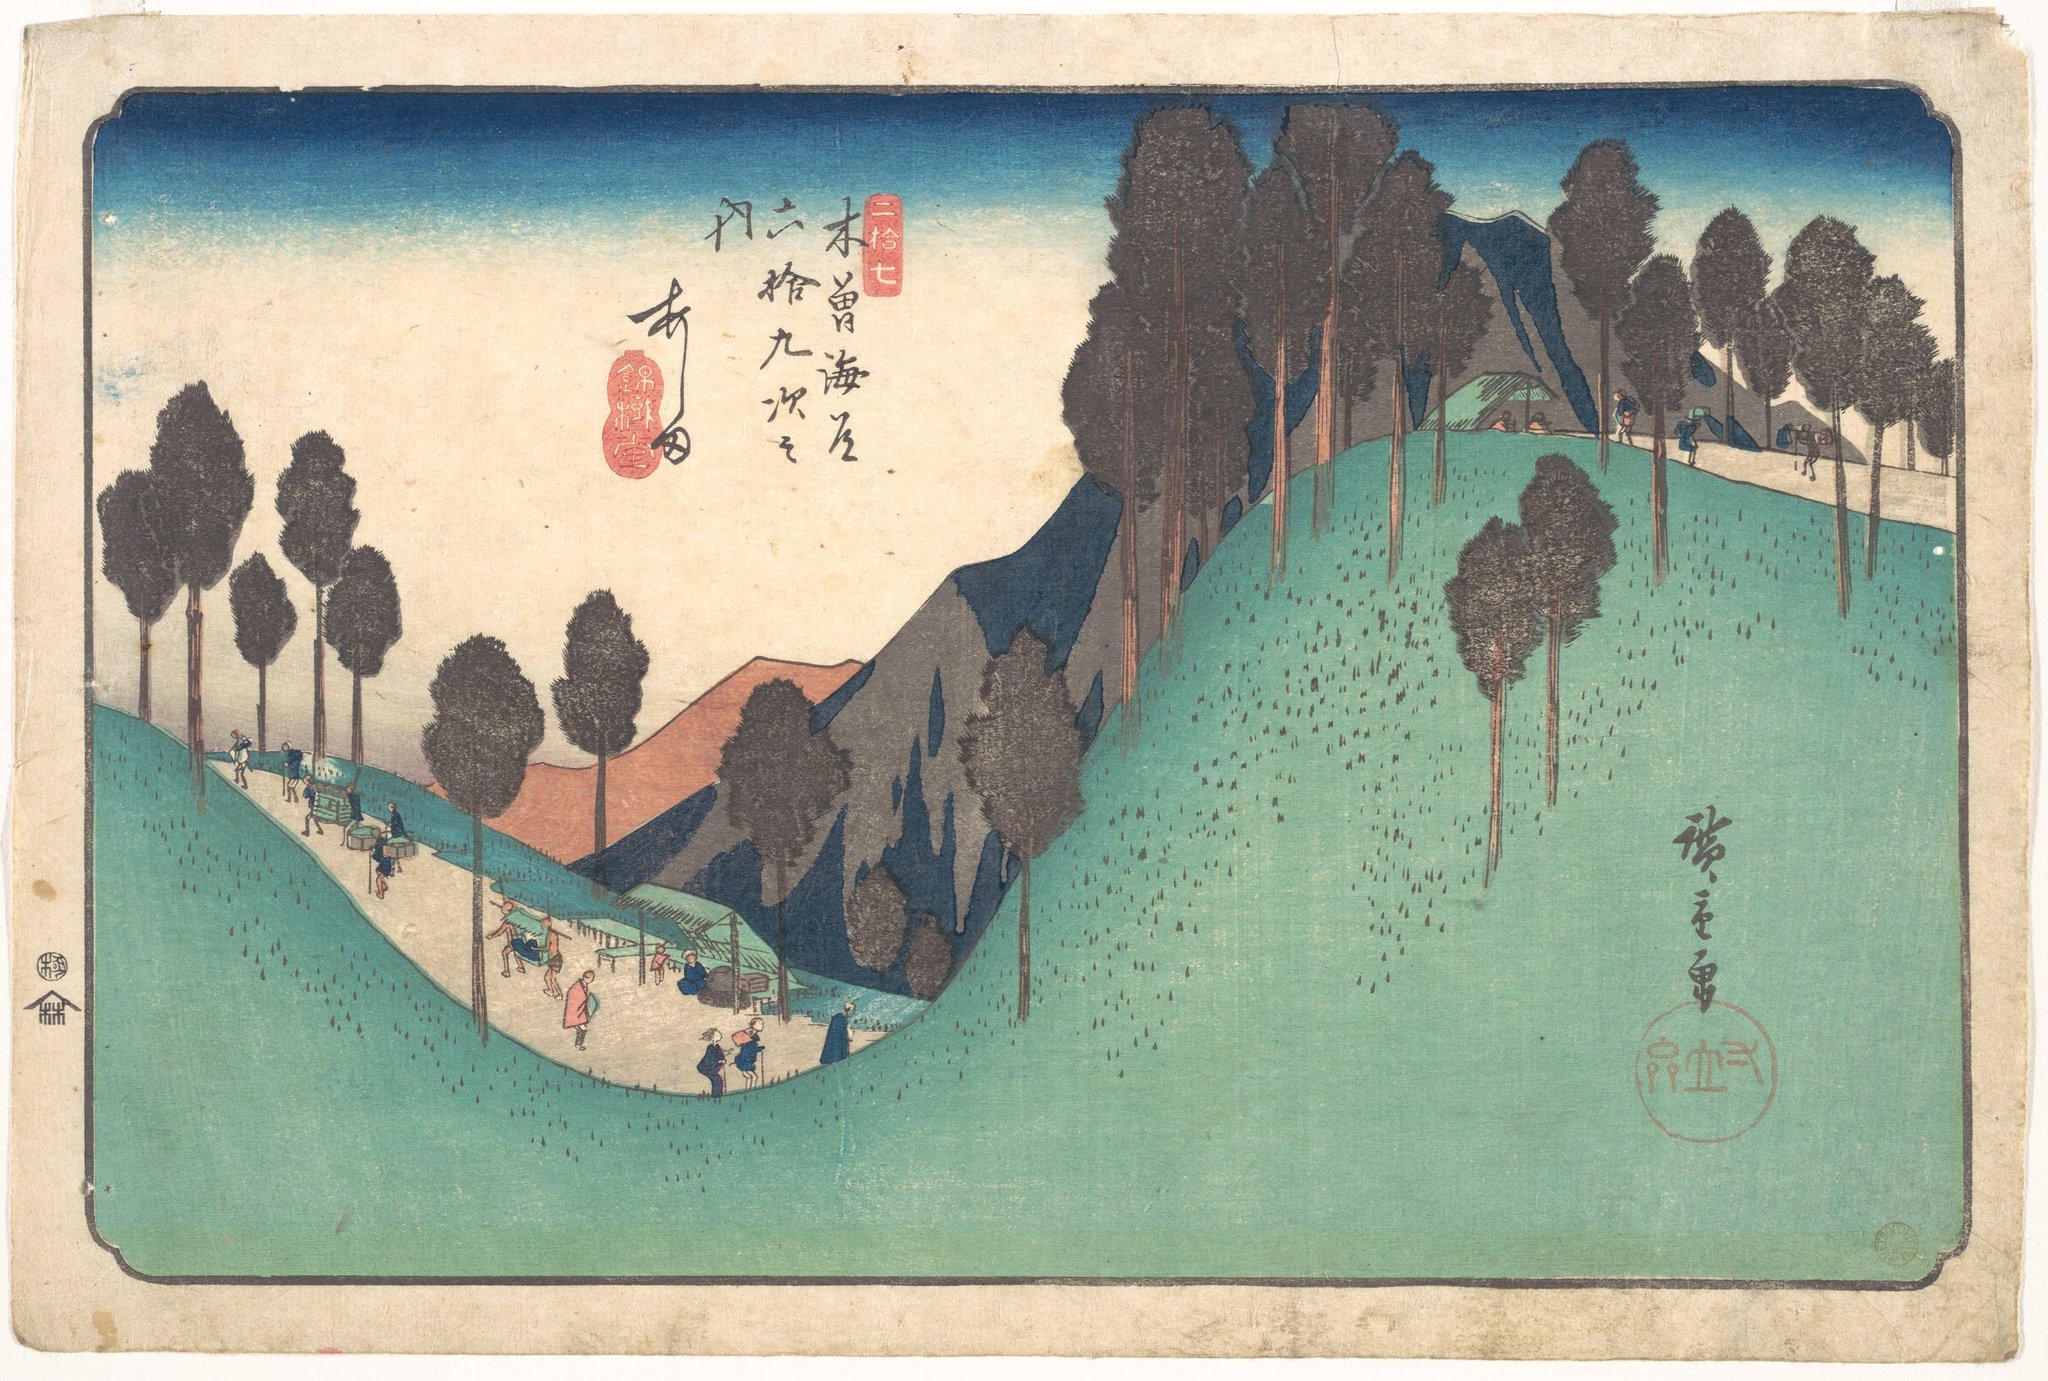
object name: print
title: Ashida Station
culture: japanese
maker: utagawa hiroshige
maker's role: artist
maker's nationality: japanese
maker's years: 1797-1858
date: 1835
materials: ink, paper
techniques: woodblock print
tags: human figures,hills,landscapes,trees